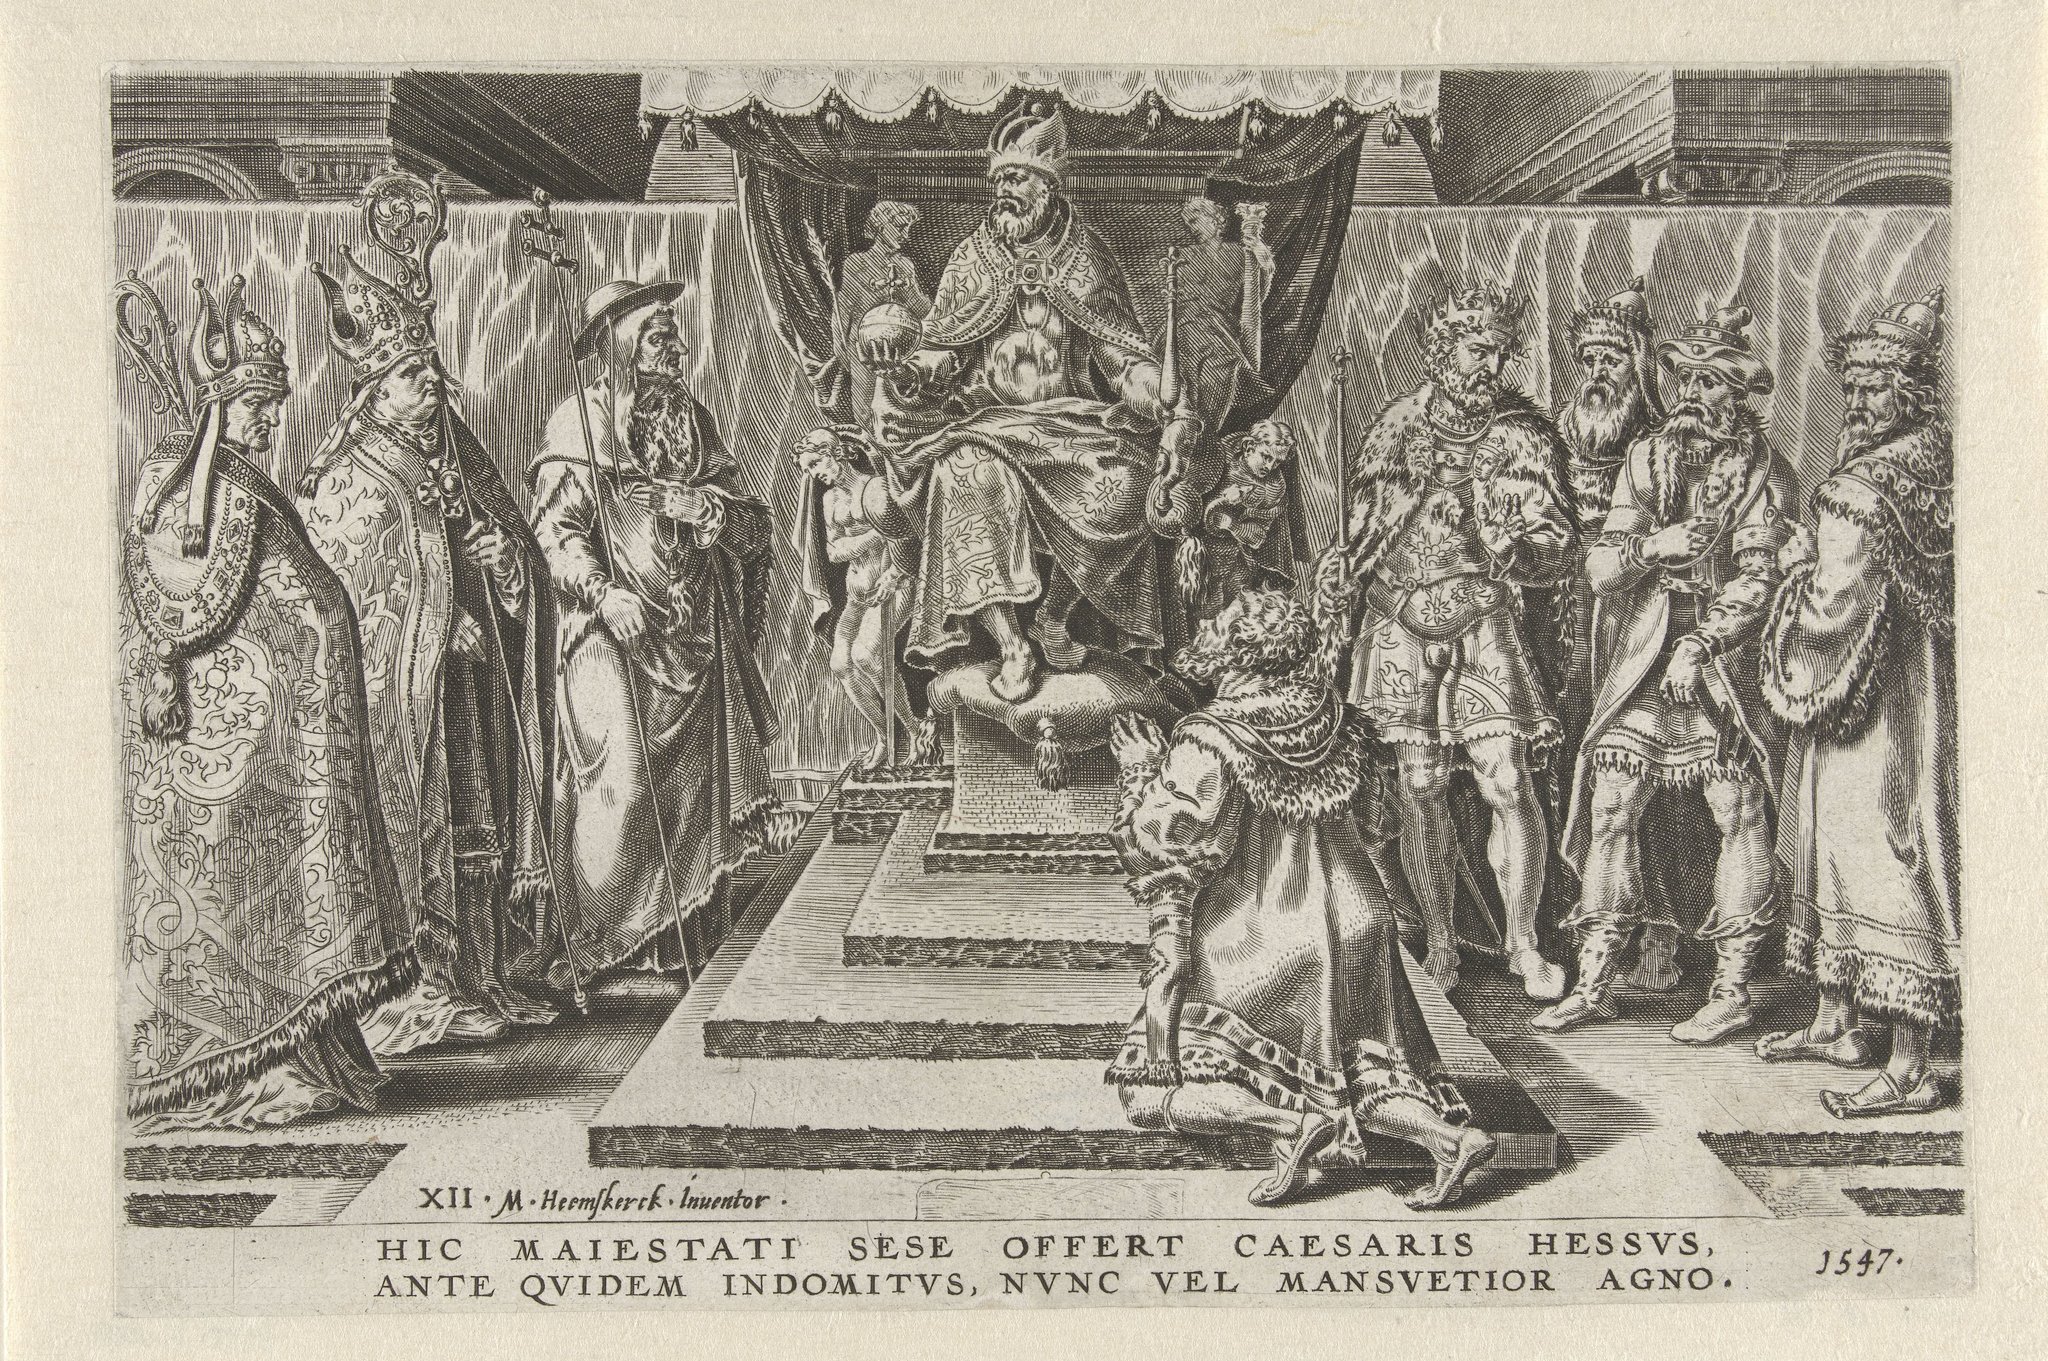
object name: history print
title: Divi Caroli. V. imp. opt. max. victoriae, ex multis praecipuae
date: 1555-1556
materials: paper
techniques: engraving, etching, letterpress printing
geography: haarlem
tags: fernando álvarez de toledo (3rd duke of alba), antoine perrenot de granvelle, nicolas perrenot de granvelle, ghent, charles v (holy roman emperor and king of spain), philip i (landgrave of hesse)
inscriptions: collector's mark: Lugt 2228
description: Filips I, landgraaf van Hesse, knielt voor de troon van Karel V in totale overgave. Links van Karel V de bisschoppen van Arras, Naumburg en Hildesheim. Rechts de hertog van Alva, de hertog van Saksen en de hertog van Brandenburg. De prent heeft een Latijns onderschrift en maakt deel uit van een twaalfdelige serie over de overwinningen van Karel V.